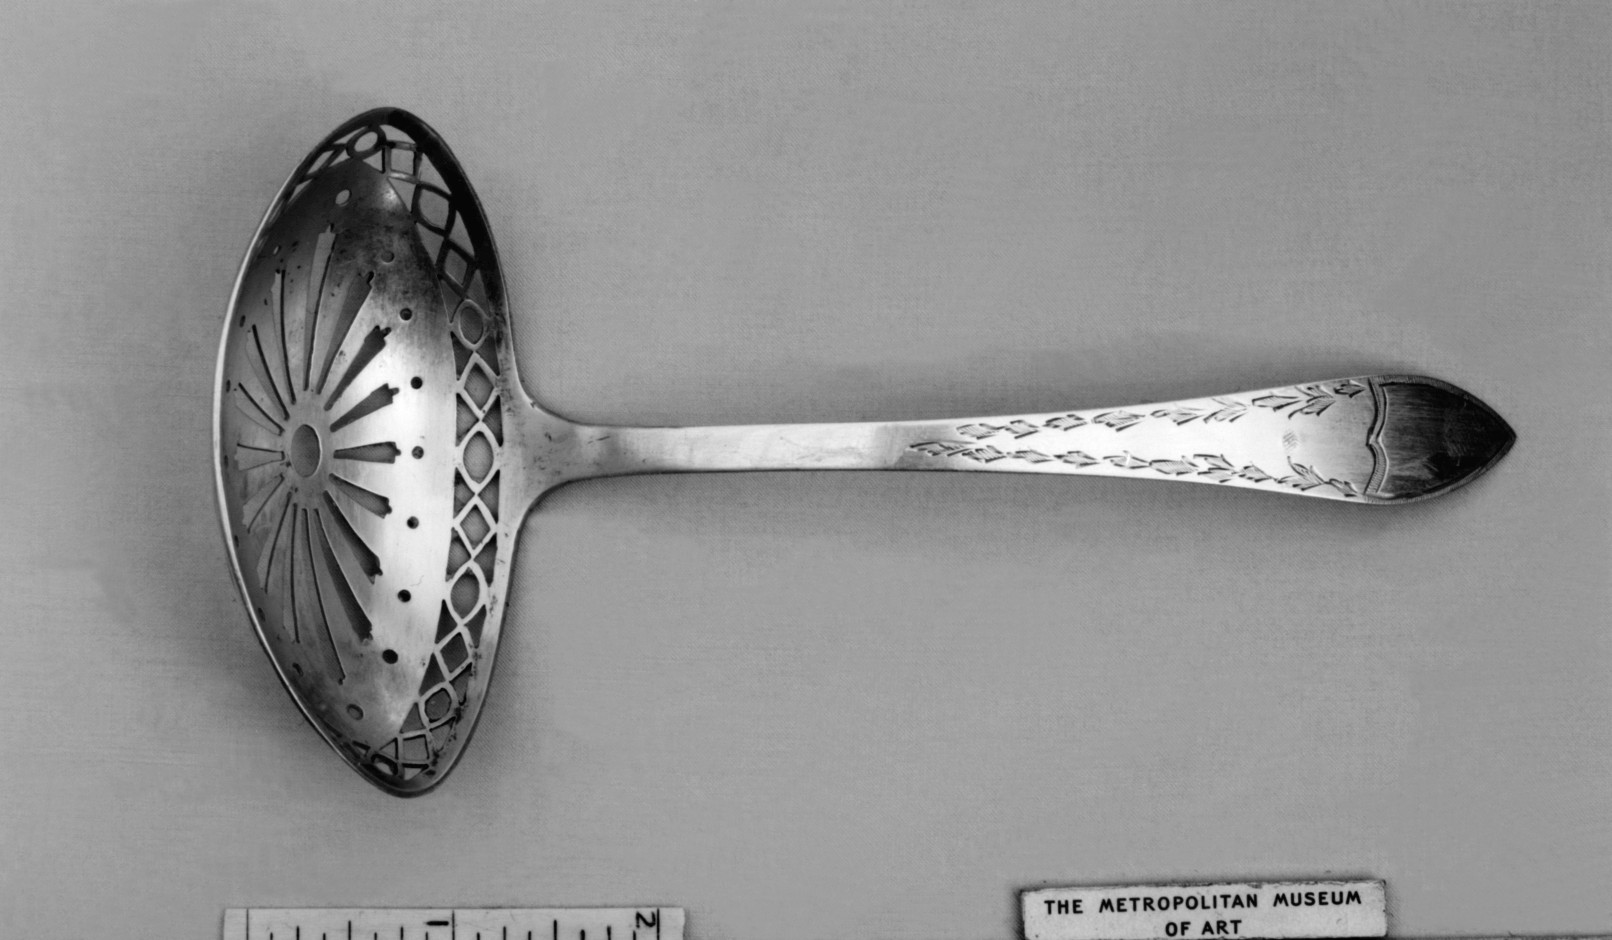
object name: sugar sifter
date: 1780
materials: silver